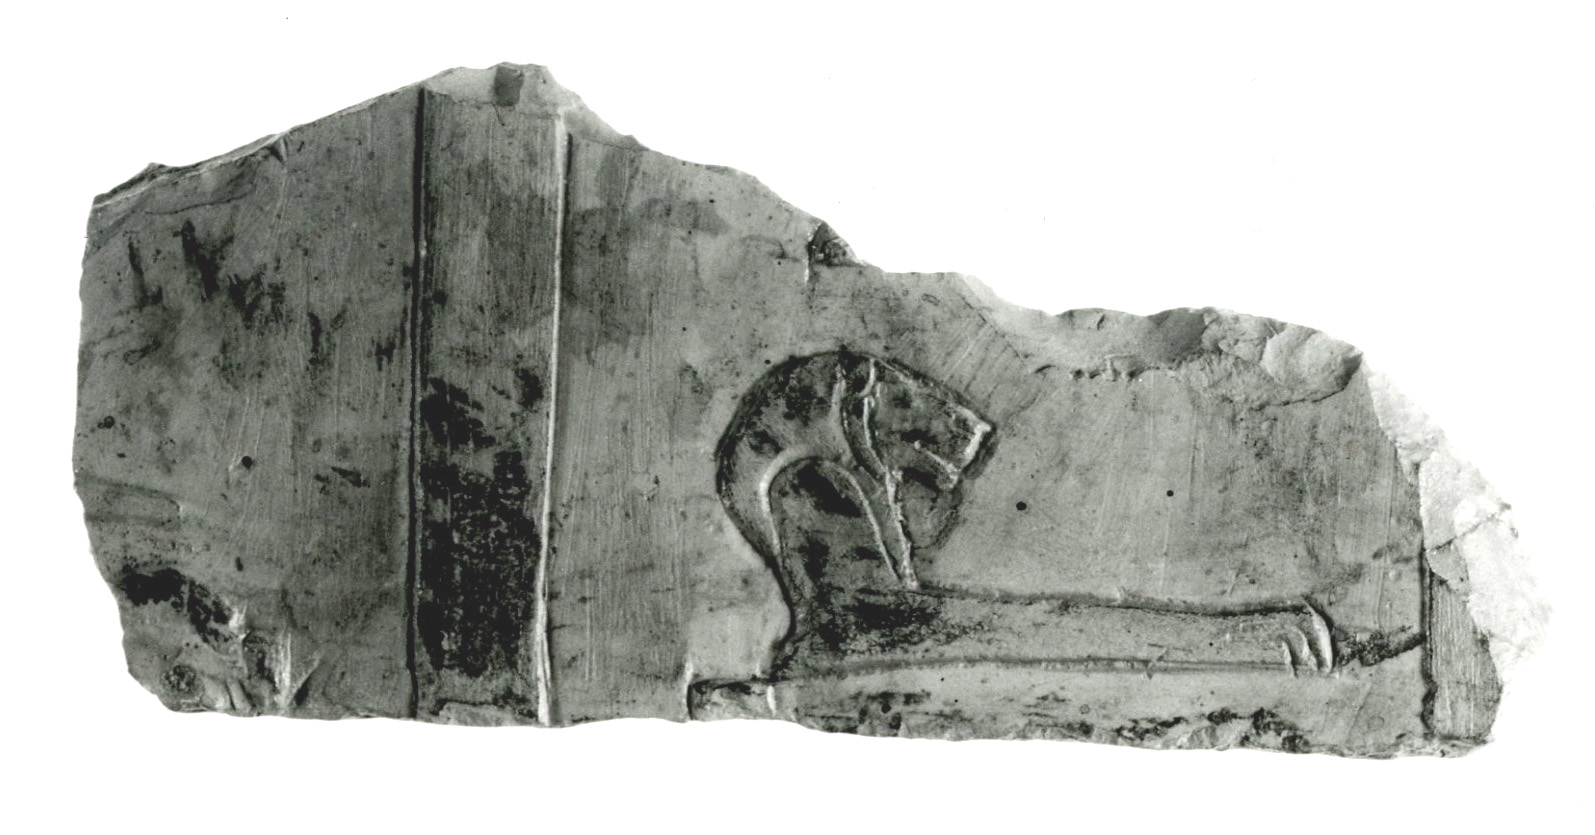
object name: relief, tomb of nespekashuty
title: Raised relief fragment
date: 664-610 BCE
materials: limestone, varnish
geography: egypt